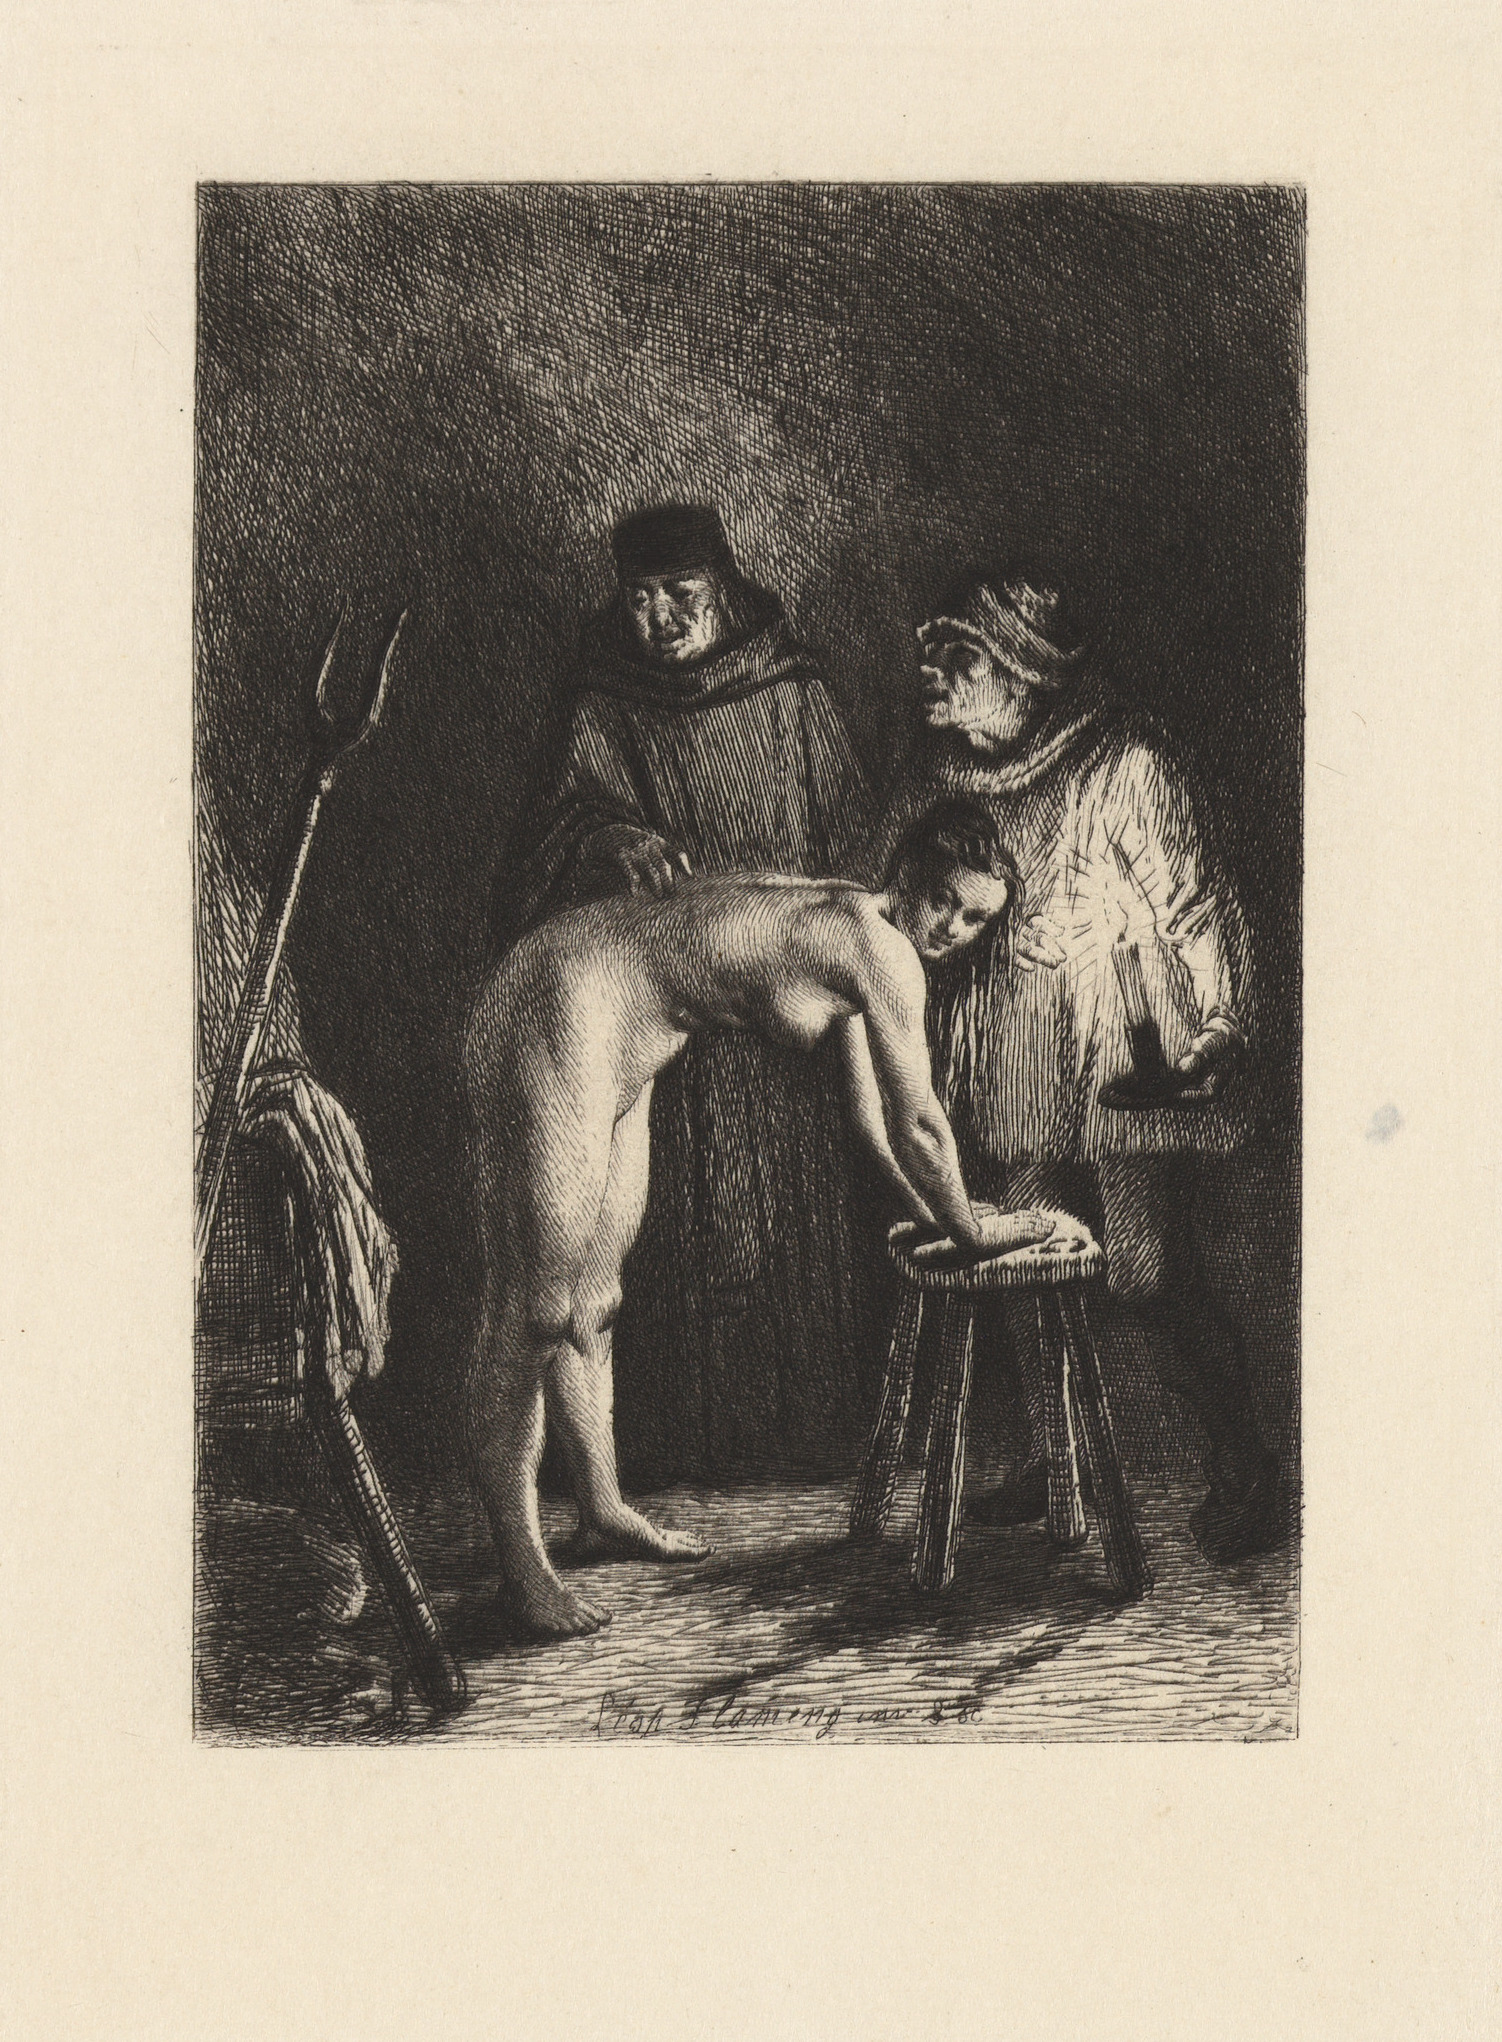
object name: print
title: La Jument du Compere Pierre, plate 9 from "The Decameron"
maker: léopold flameng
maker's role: engraver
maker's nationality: french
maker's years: 1831-1911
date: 1873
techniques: etching